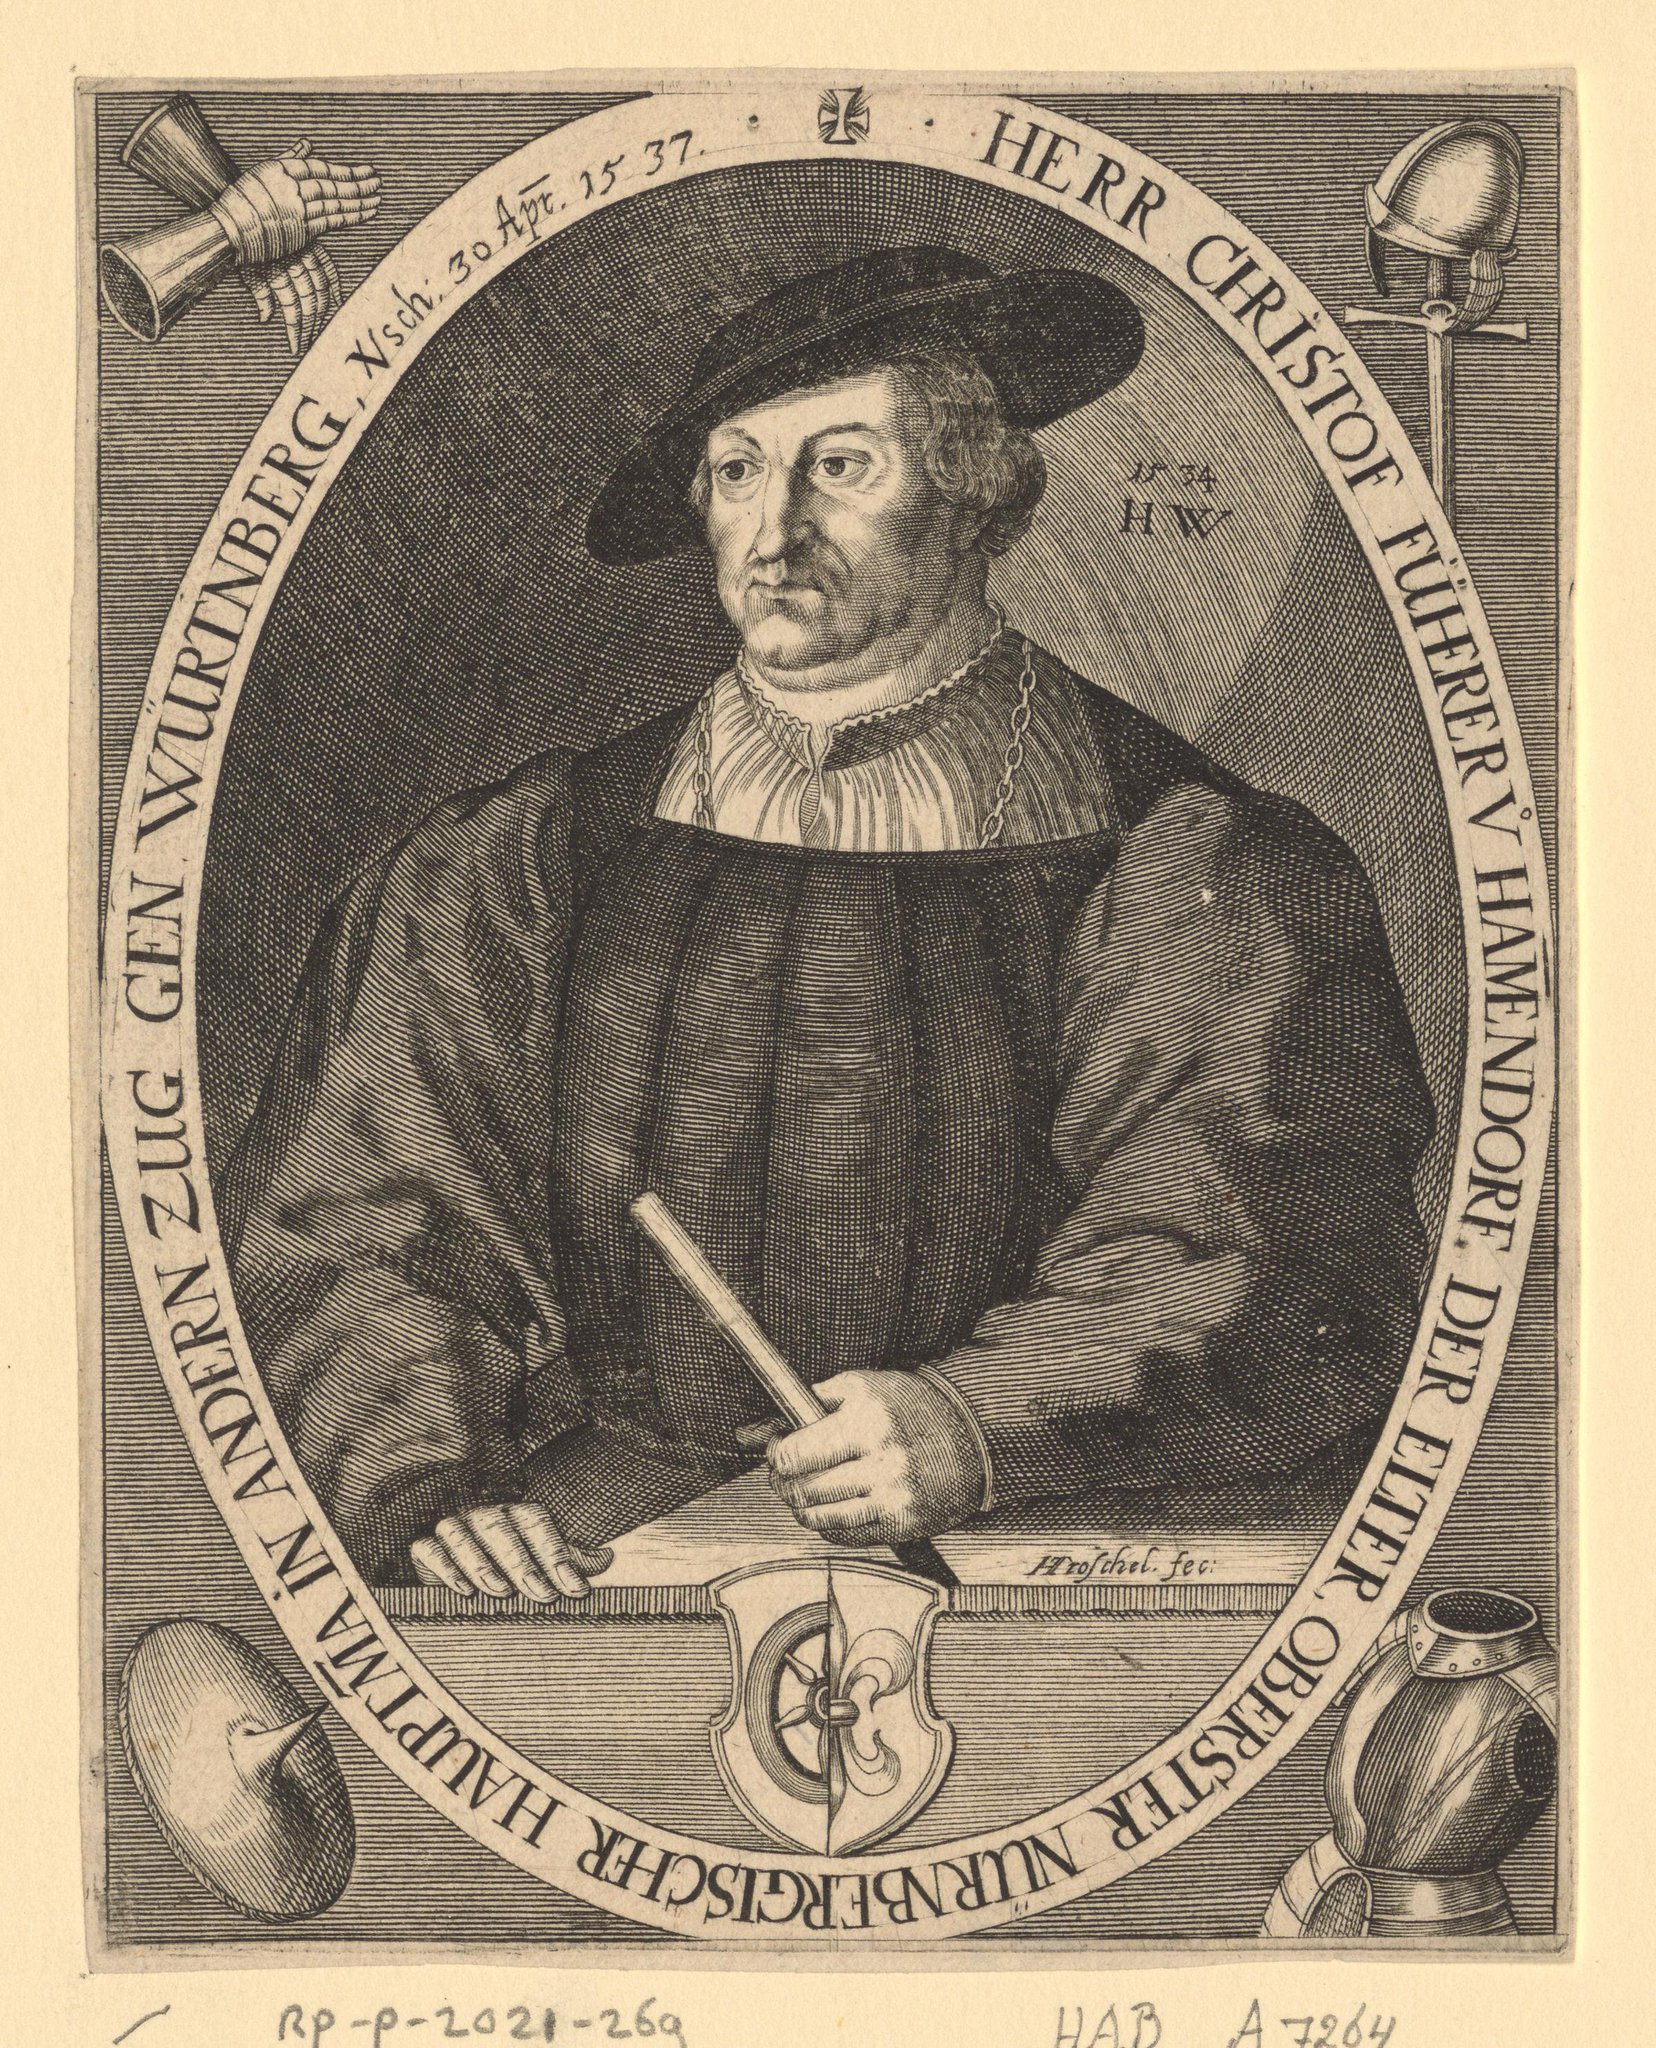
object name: print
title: Portret van Christoph I Fürer von Haimendorf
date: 1595-1628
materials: paper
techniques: engraving, etching, letterpress printing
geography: germany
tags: helmet, armour, historical persons, armorial bearing, heraldry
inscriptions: monogram: ‘HW’